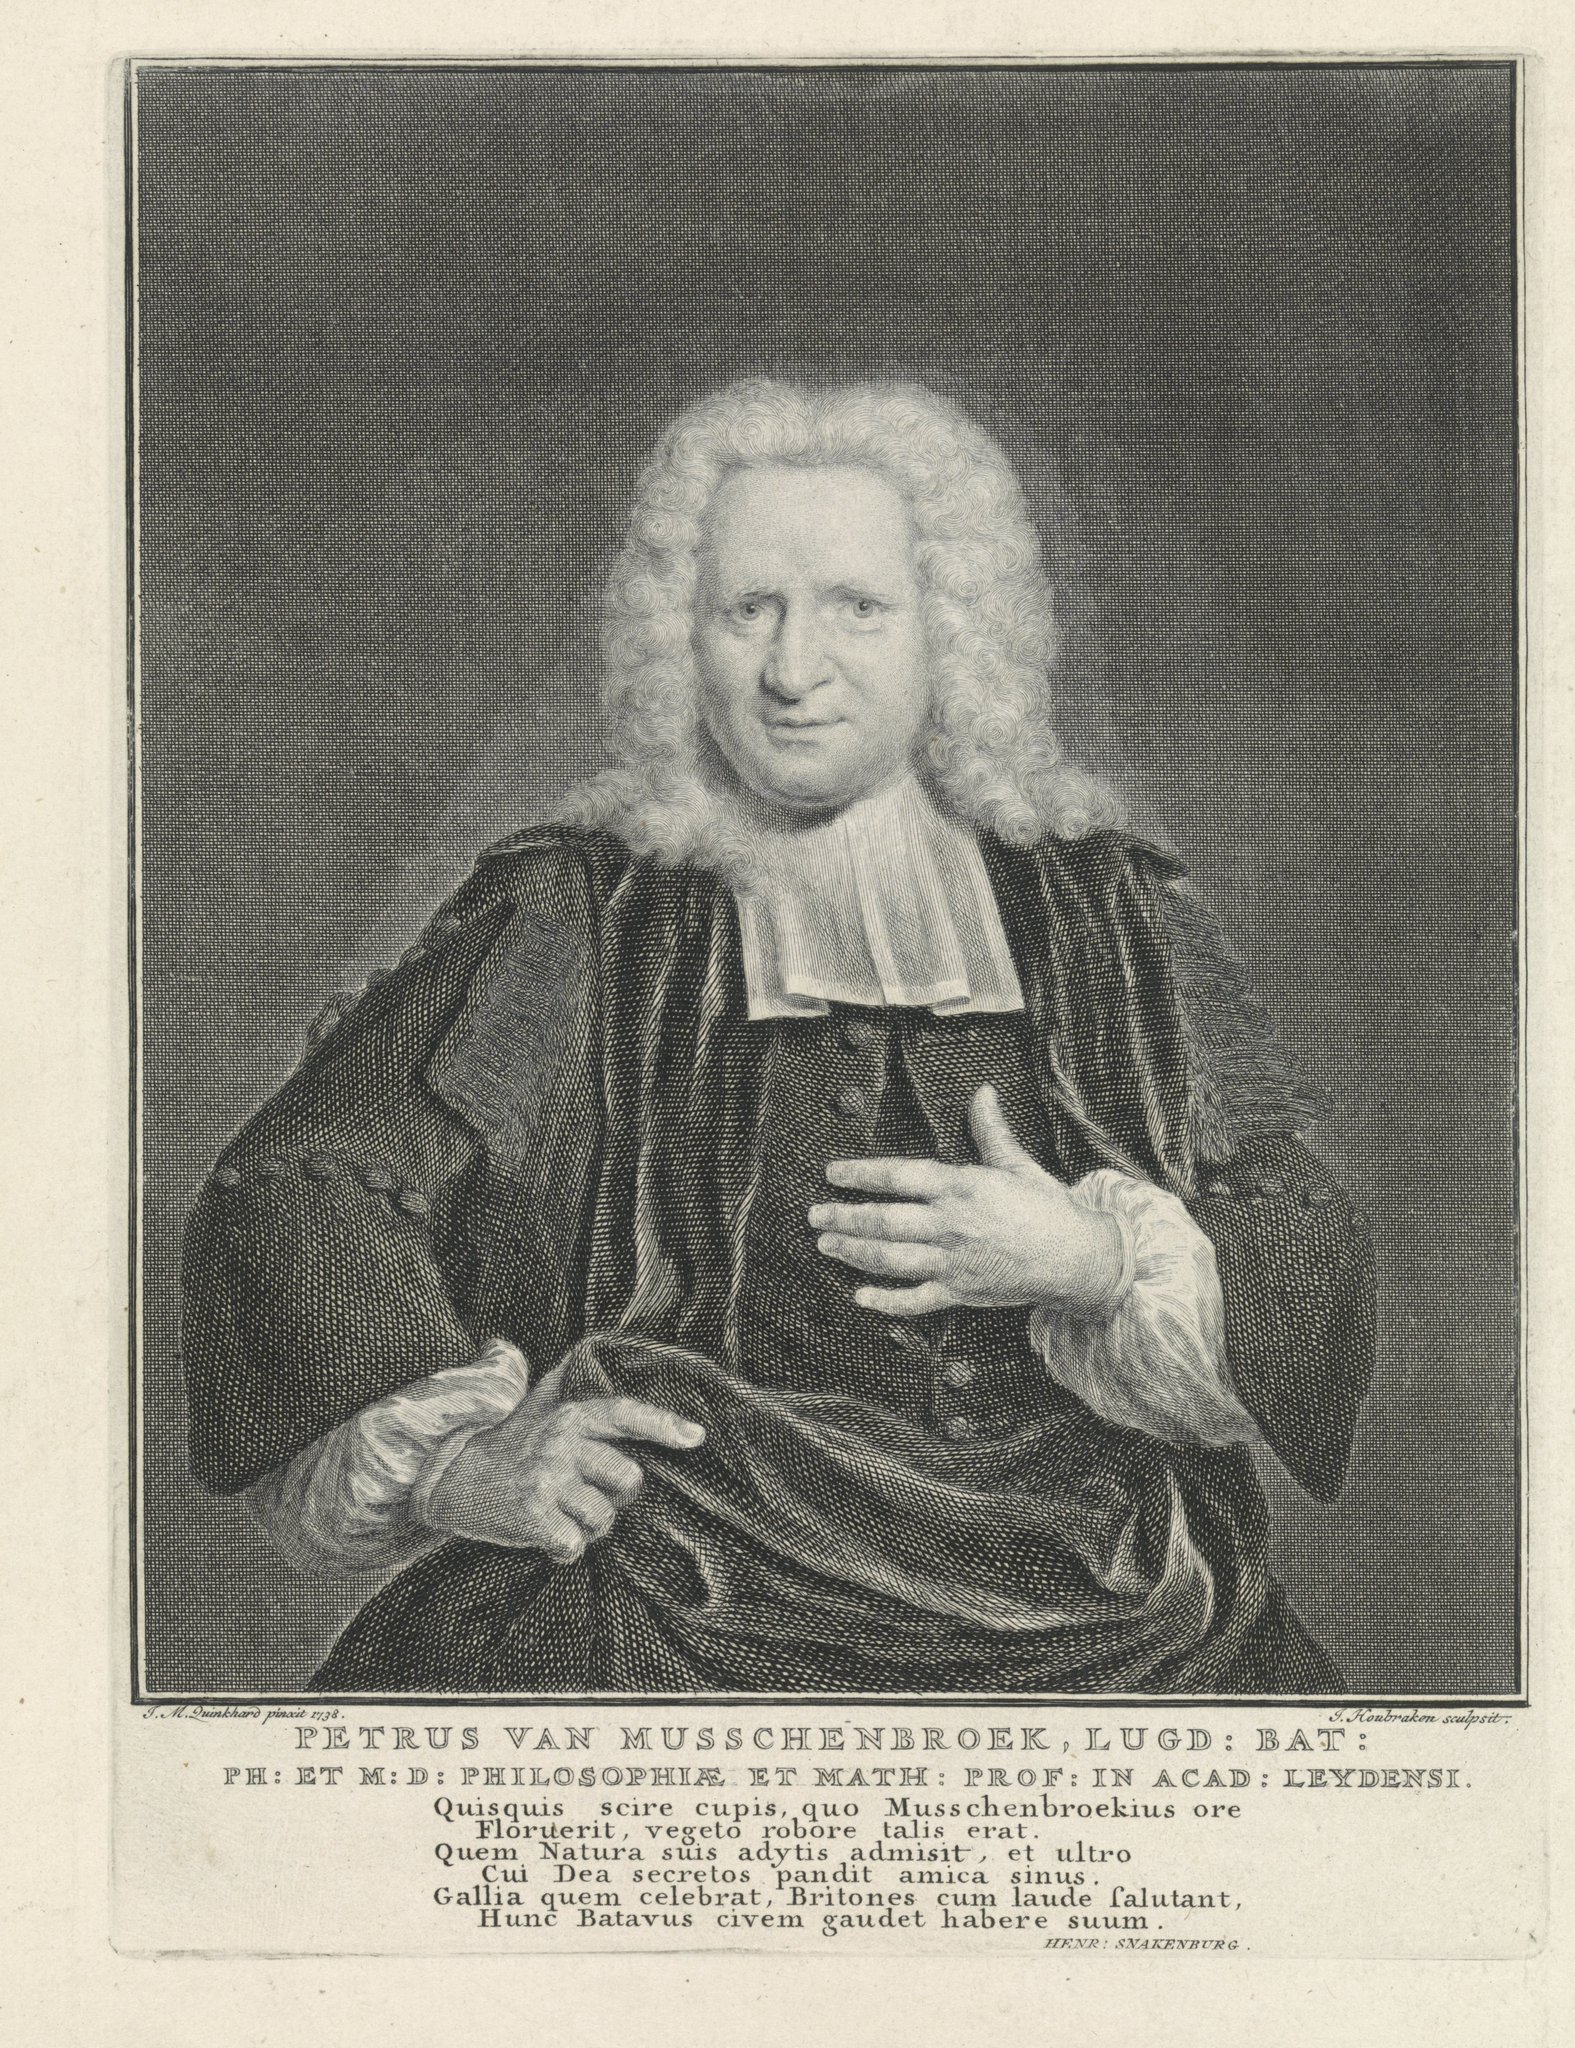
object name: print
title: Portret van Petrus van Musschenbroek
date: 1740-1780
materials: paper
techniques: engraving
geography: amsterdam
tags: leiden, physicist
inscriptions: collector's mark: Lugt 2228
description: Portret ten halven lijve van Petrus van Musschenbroek. Onder het portret zijn naam en gegevens in twee regels in het Latijn en daaronder een zesregelige tekst in het Latijn.